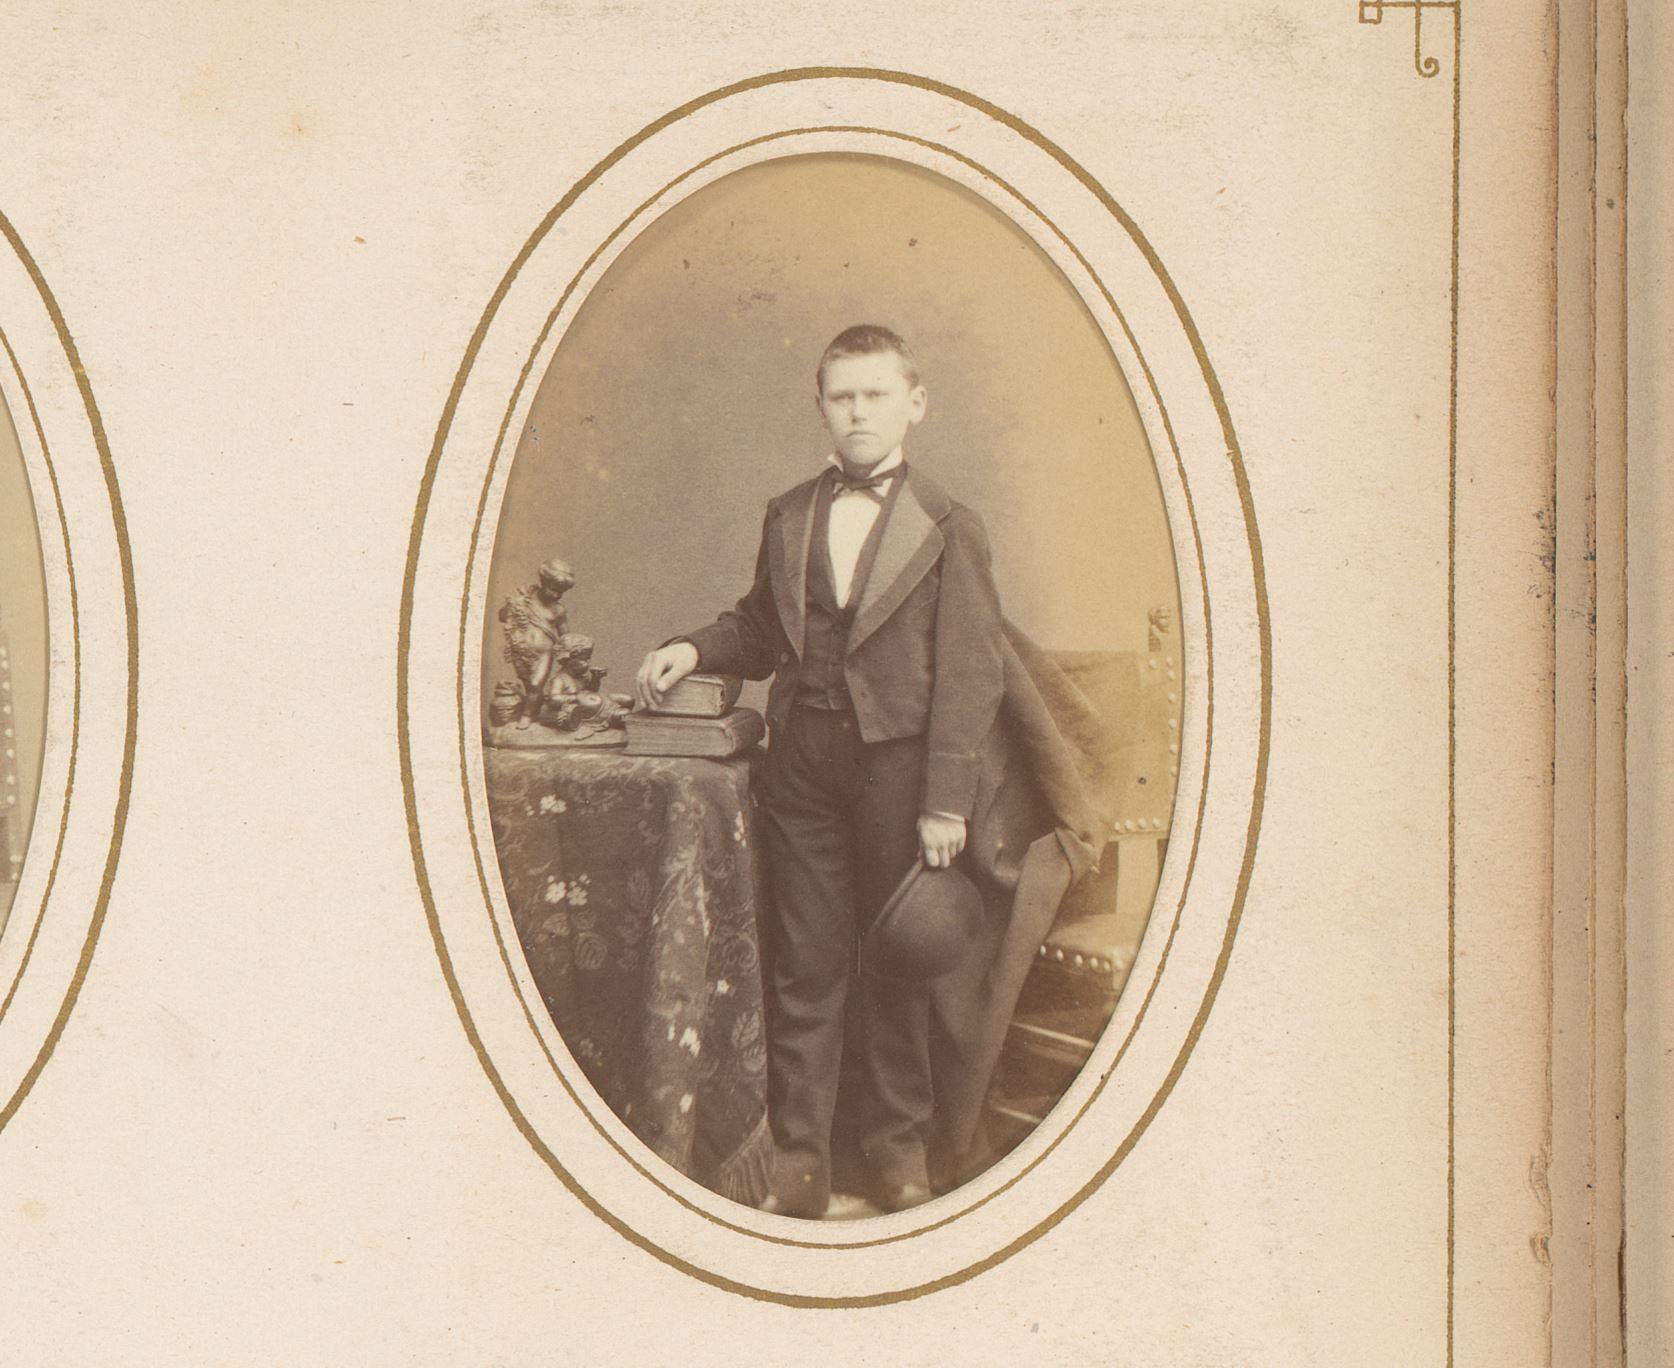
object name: photograph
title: Portret van een jongen met hoed in de hand, staand tussen een tafel met boeken en een stoel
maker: eugene guérin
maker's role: fotograaf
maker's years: 1845-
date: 1875-1885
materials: cardboard, photographic support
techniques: albumen print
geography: brussels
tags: boy (child between toddler and youth), historical persons, table, book, chair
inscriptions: inscription: ‘Eugène Guérin/ 142, Rue Royale, 142/ Bruxelles’